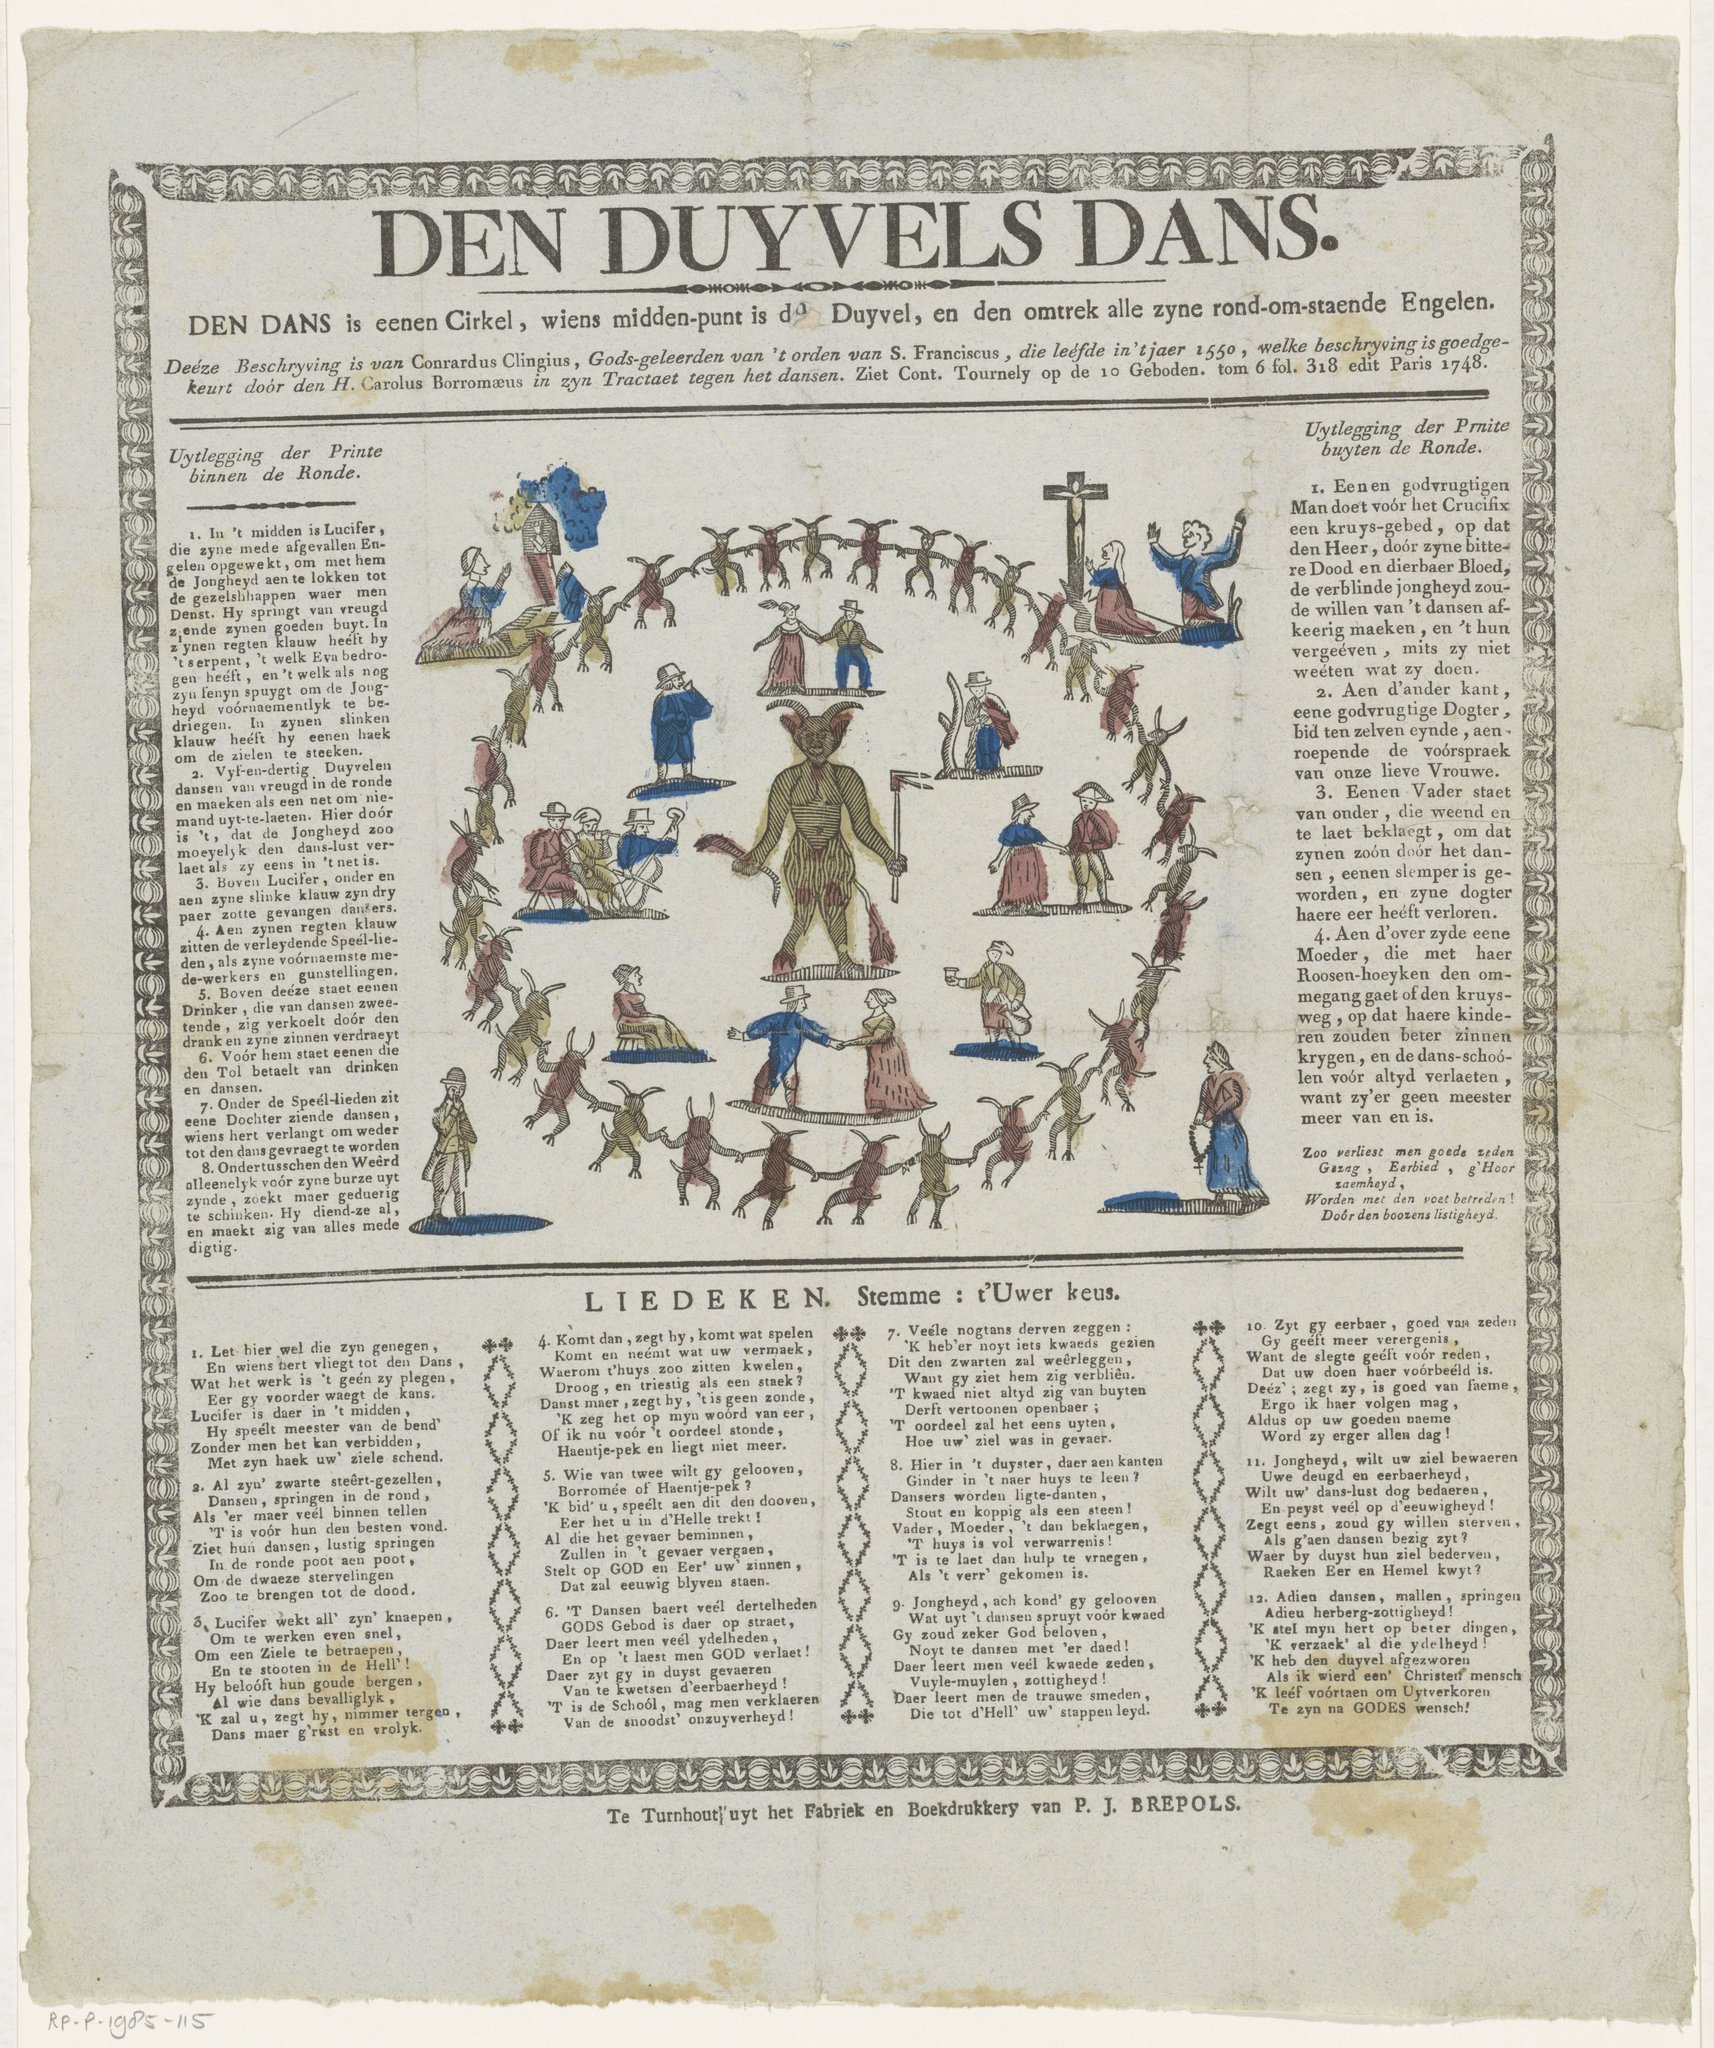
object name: popular print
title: Den Duyvels Dans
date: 1800-1833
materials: paper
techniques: colour, letterpress printing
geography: turnhout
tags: devil(s) and demons, group dancing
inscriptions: collector's mark: Lugt 2228, collector's mark: Lugt 2760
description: Een kring van dansende duivels met daarin dansende en musicerende boeren en een grote duivel. Rondom de kring biddende mensen. De voorstelling wordt omgeven door tekst in boekdruk. Geheel omgeven door een sierlijst.